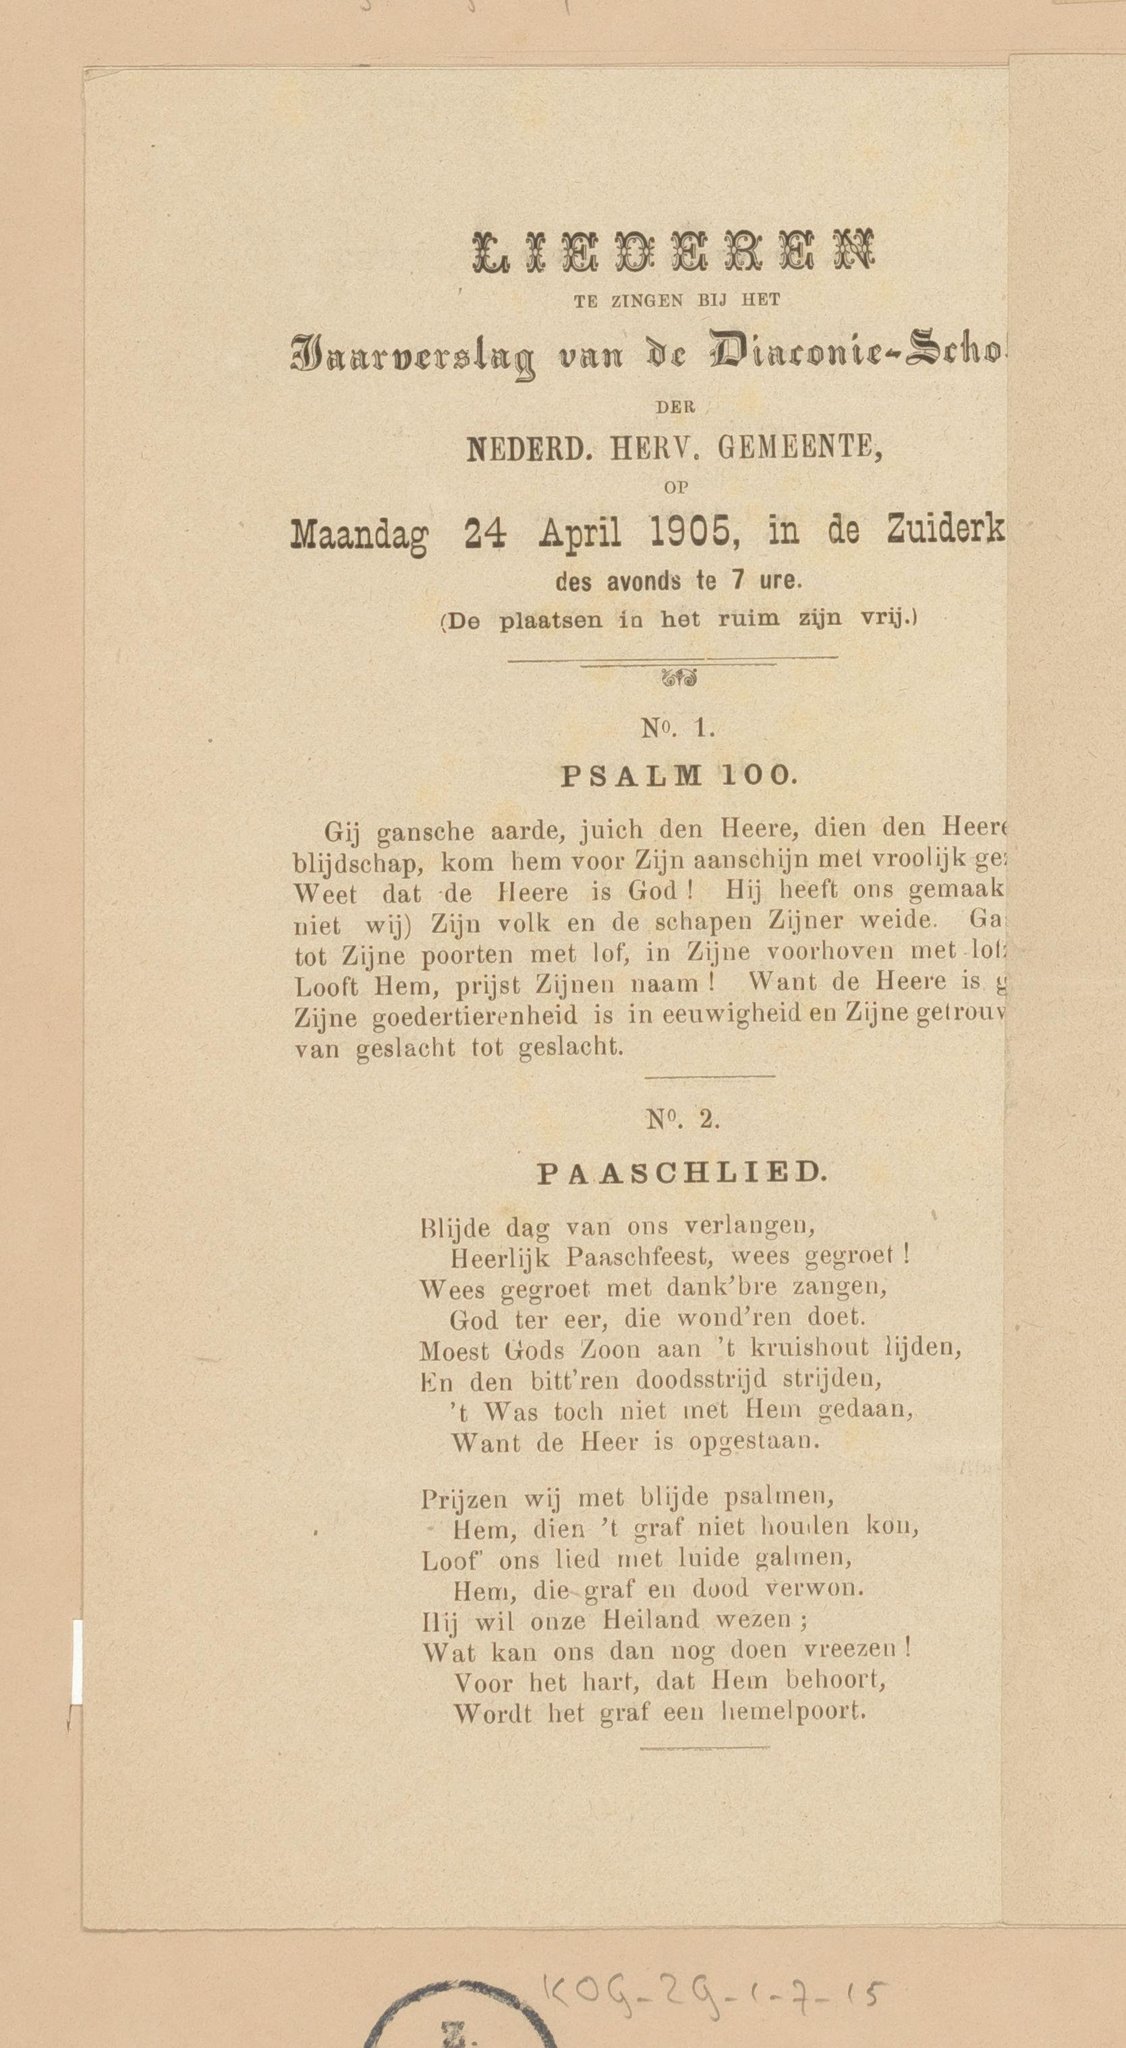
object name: song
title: Liederen te zingen bij het Jaarverslag van de Diaconie-Scholen der Nederd. Herv. Gemeente (...)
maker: Anonymous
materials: paper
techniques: letterpress printing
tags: zuiderkerk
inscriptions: collector's mark: Lugt 1641, stamp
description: Liedboek voor de presentatie van het jaarverslag van de Diaconie-scholen, 1905. Heb boek bestaat uit vier gevouwen pagina's en is op alle zijde bedrukt. Op de eerste twee pagina's zijn diverse liedtekst gedrukt en op de laatste twee bladen staan een aankondiging van de komende collecte. Onderwerpsrubrieken binnen de Atlas Zeden en Gewoonten: Godsdienst, Ned. Hervormden, (Oudtijds Gereformeerden).